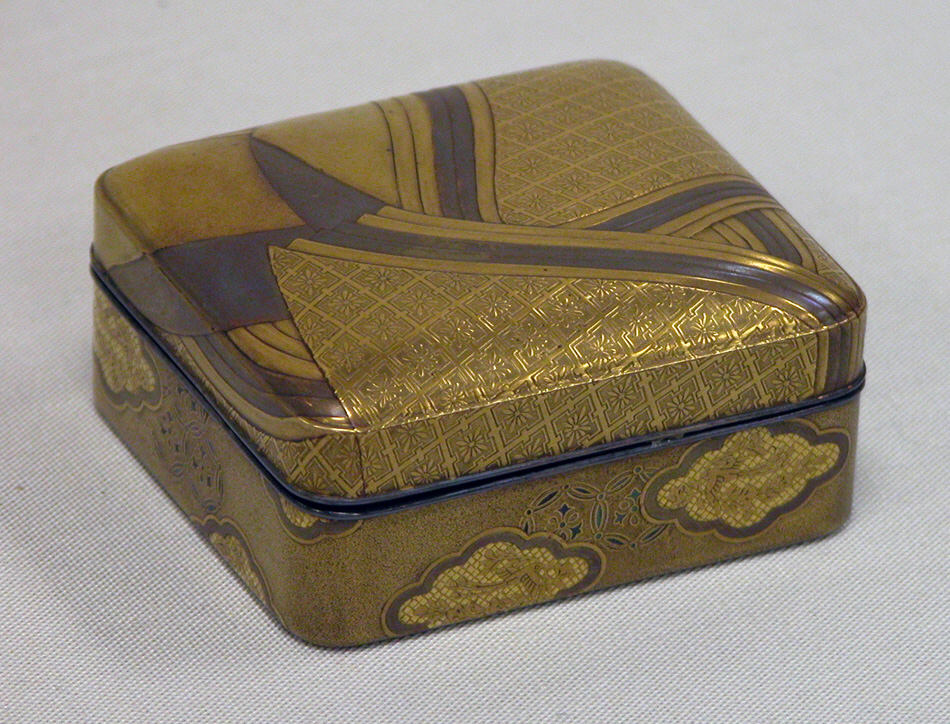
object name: kobako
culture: japanese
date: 1701-1800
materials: gold, lacquer, mother of pearl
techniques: inlay